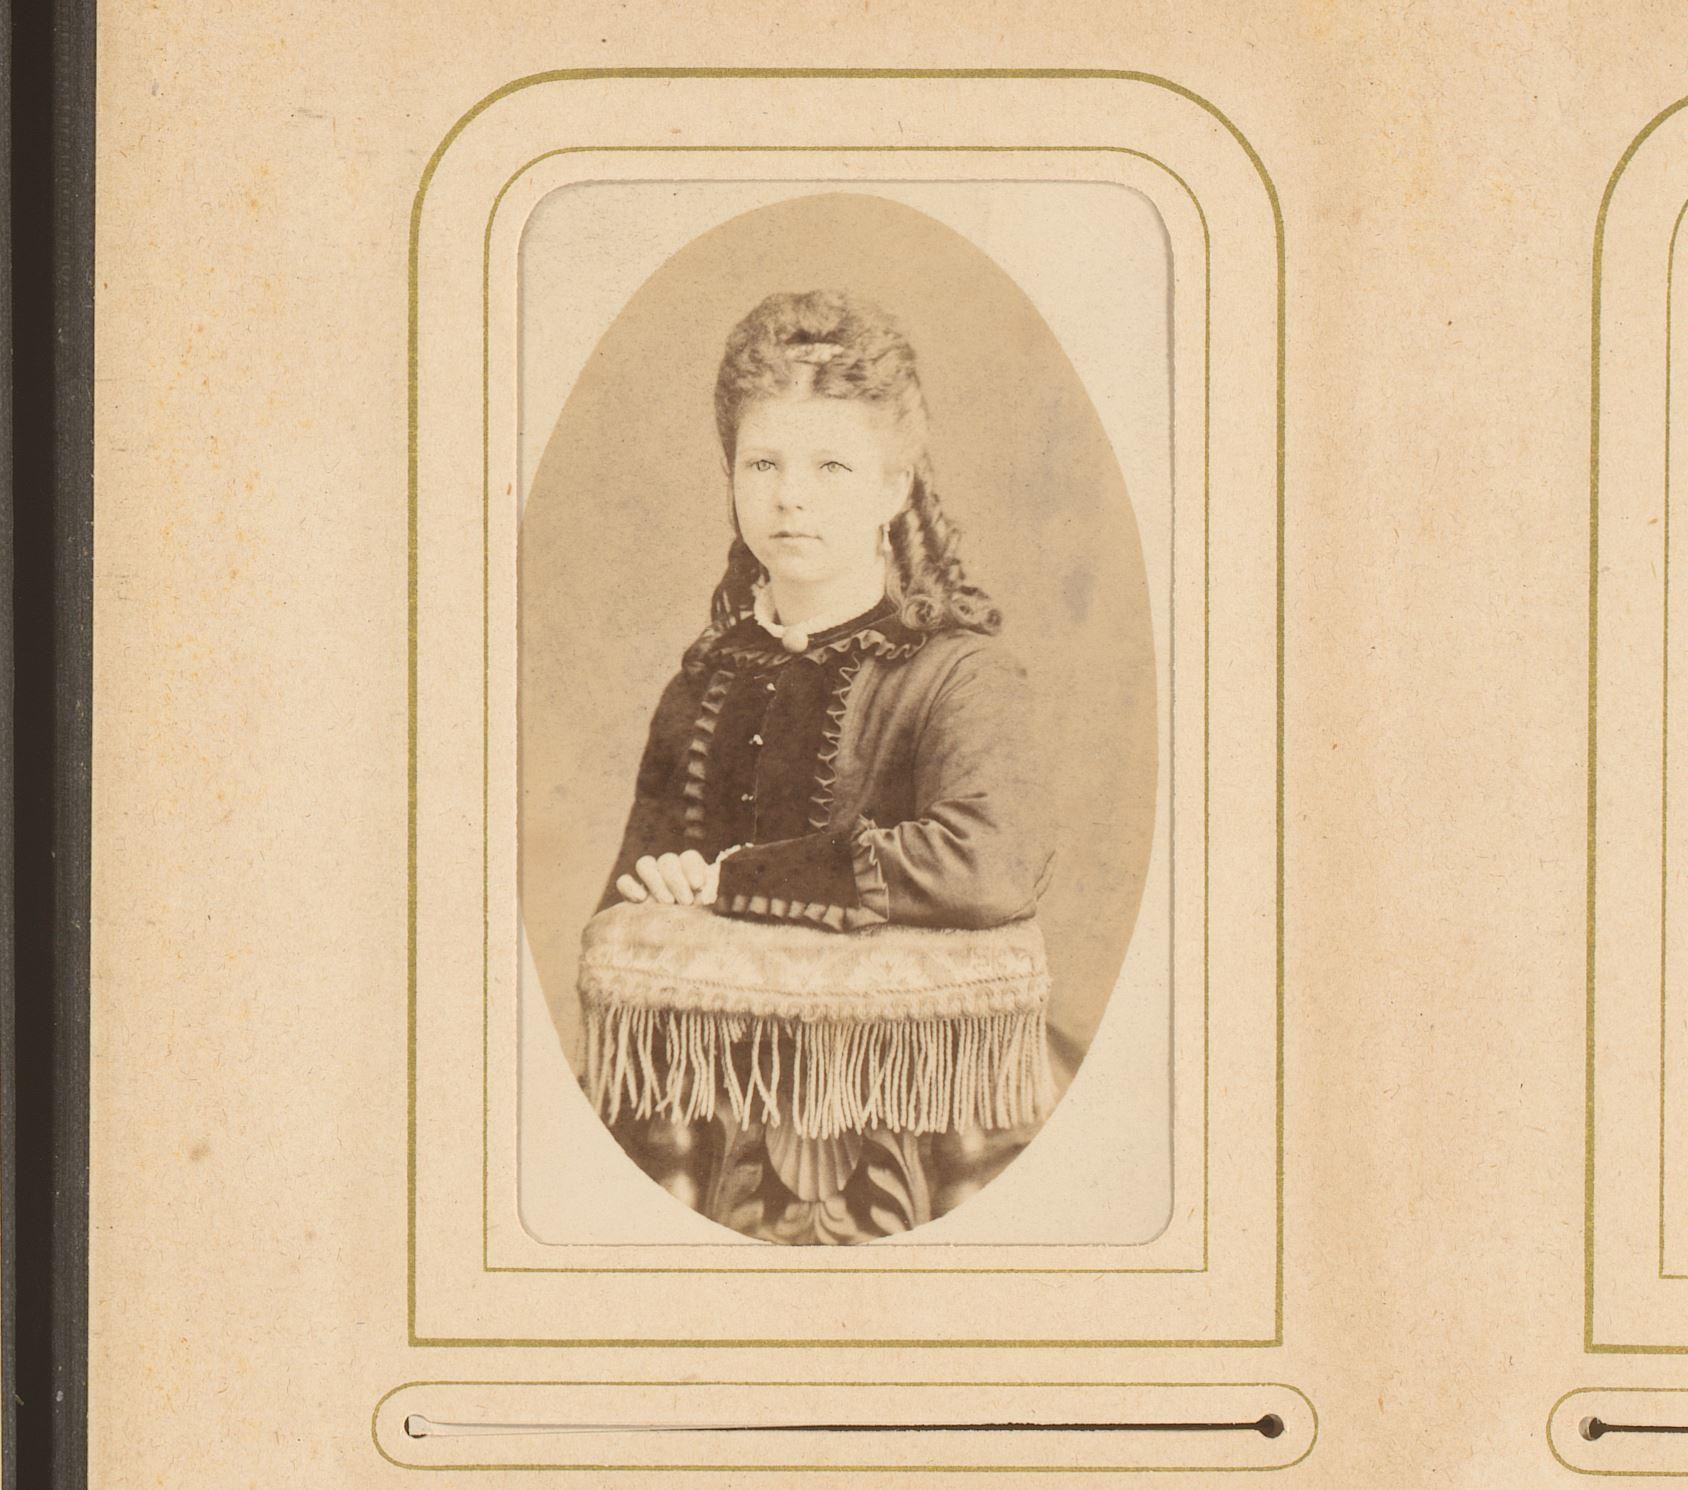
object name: album leaf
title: Portret van een zittende vrouw, leunend op de leuning van een stoel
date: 1860-1900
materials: cardboard, photographic support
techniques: albumen print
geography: nieuwediep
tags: sitting figure - aa - female human figure, historical persons - bb - woman, chair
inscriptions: inscription: ‘Photographisch/ Atelier/ A.C. Weijens/ Nieuwediep.’